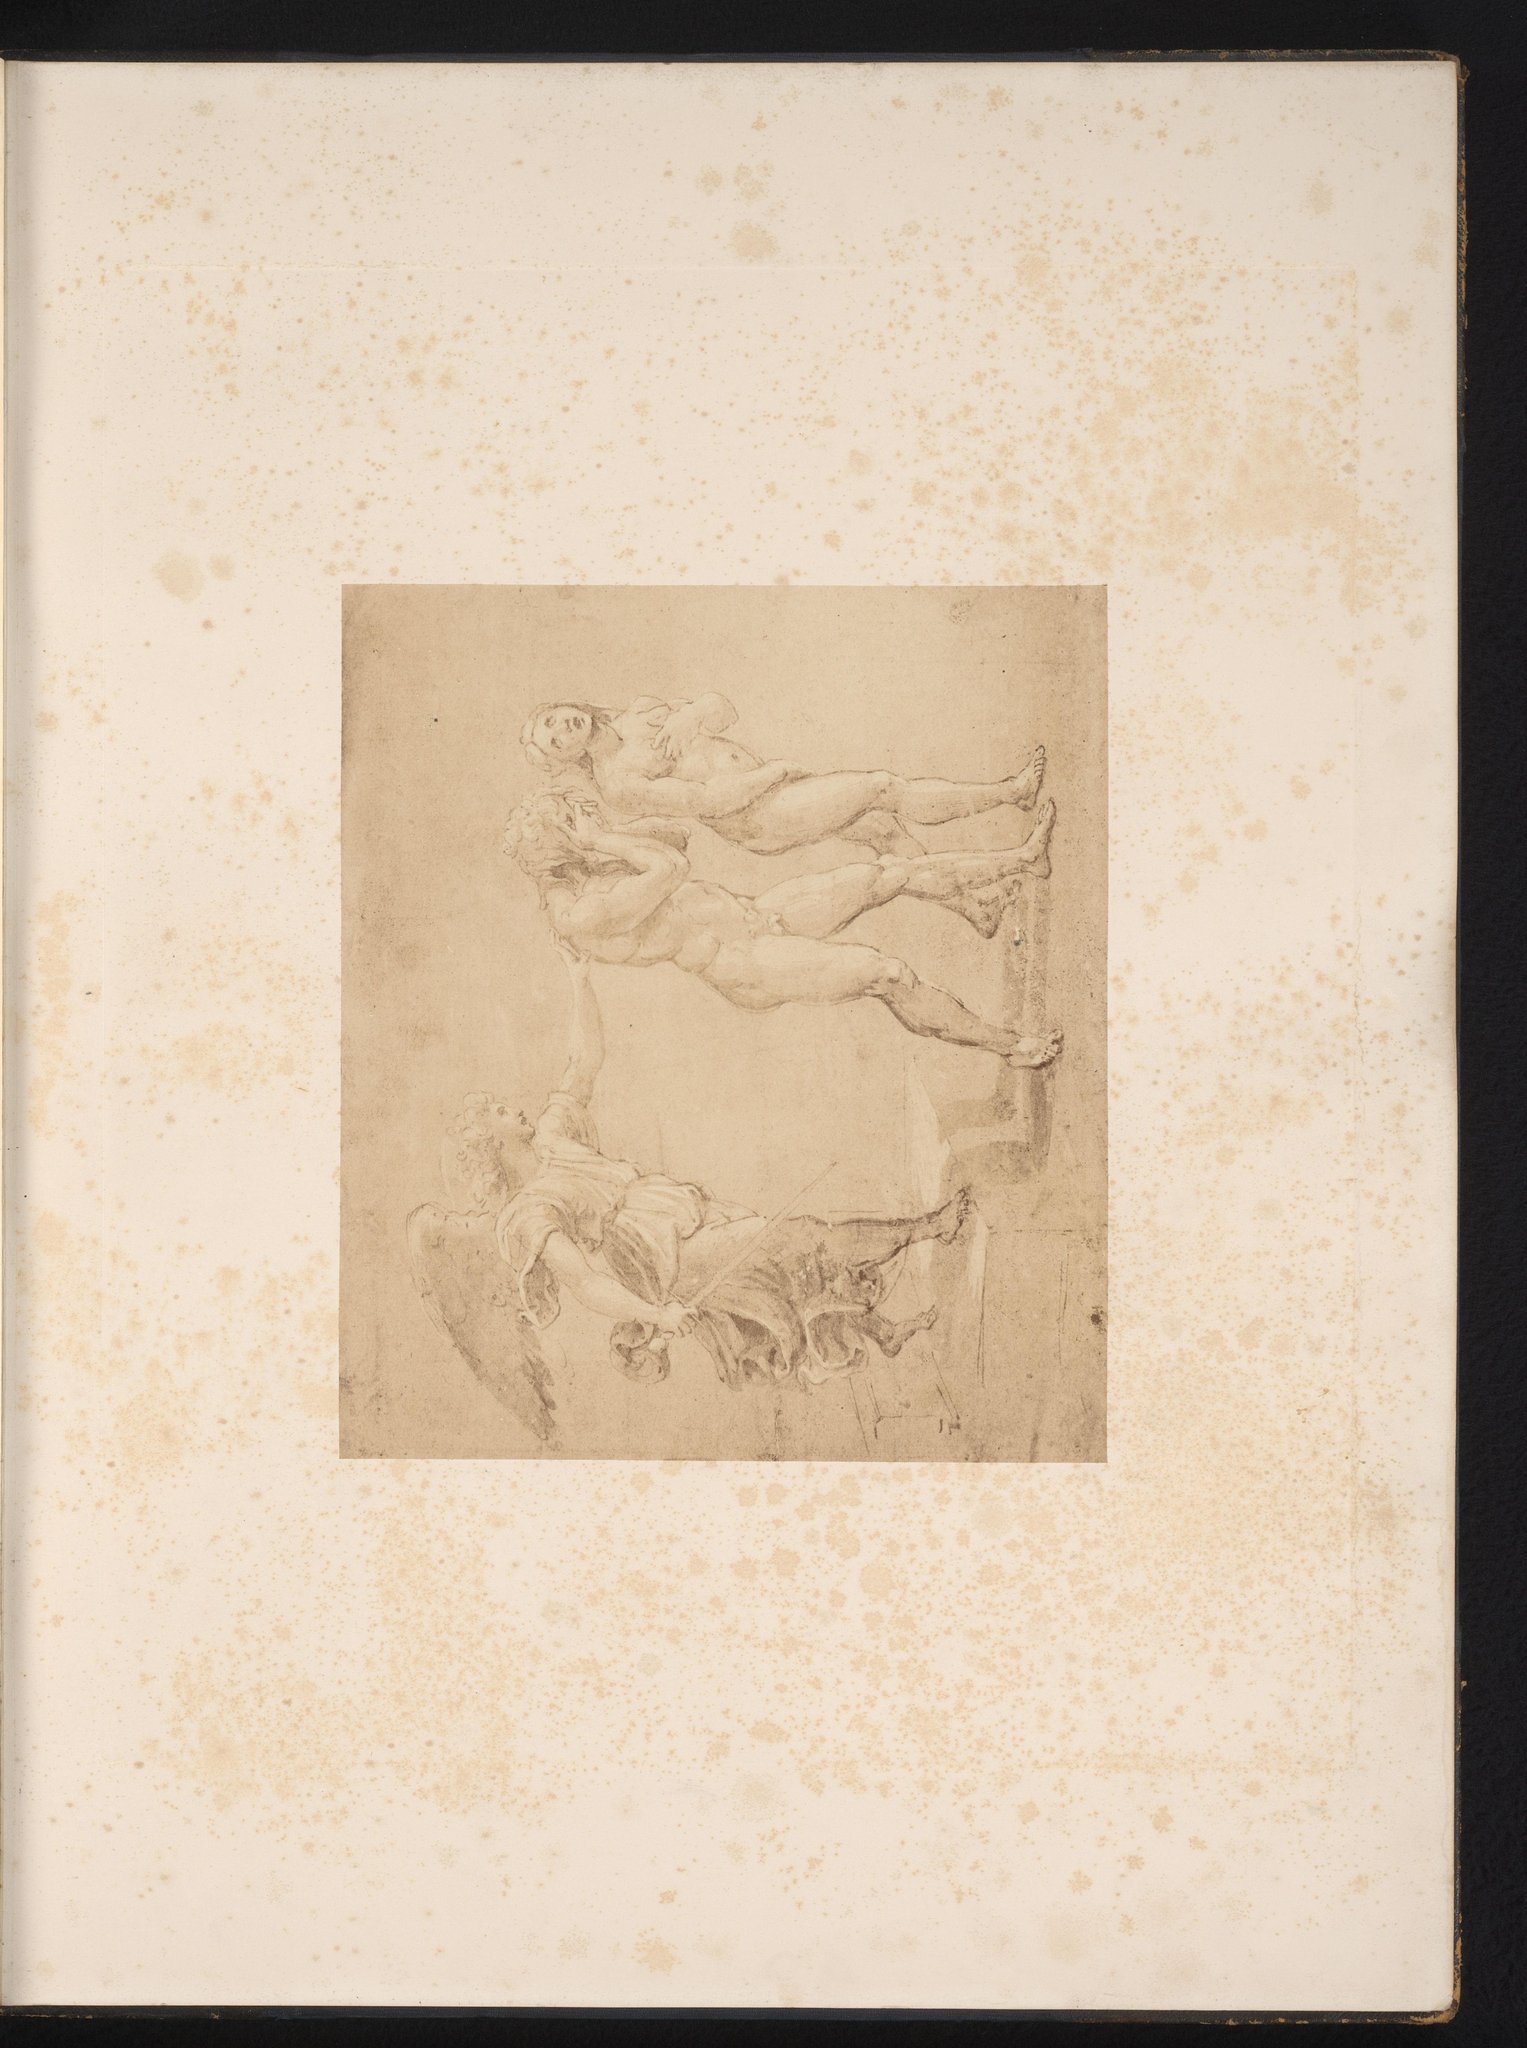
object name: reproduction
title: Fotoreproductie van een tekening van Rafaël, de verdrijving van Adam en Eva uit het paradijs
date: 1852-1857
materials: paper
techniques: albumen print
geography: windsor castle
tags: expulsion of adam and eve from paradise (genesis 3:22-24)